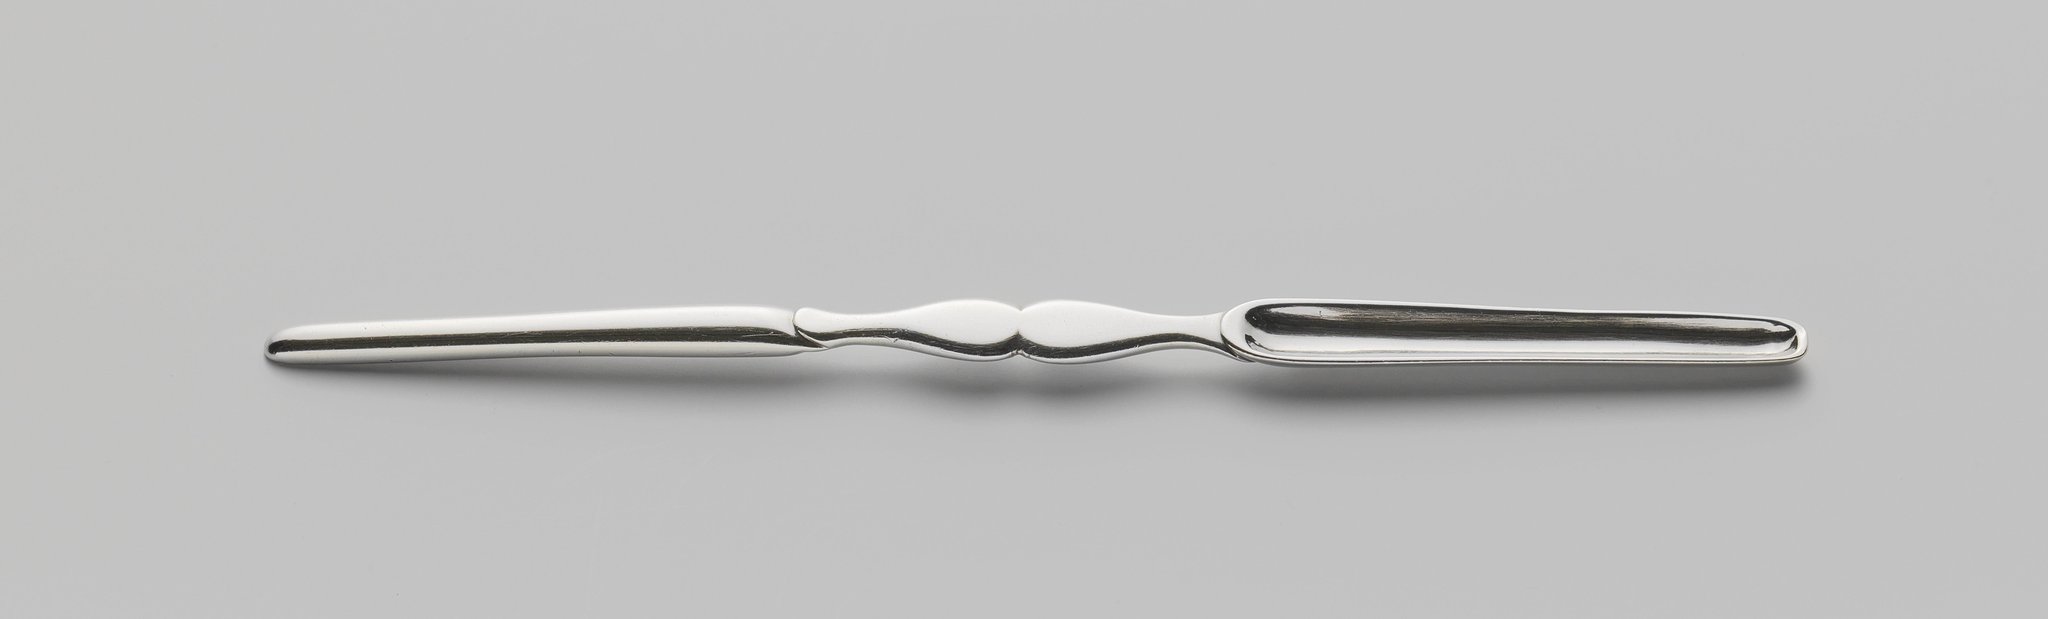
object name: marrow scoop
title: Mergboor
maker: johannes keeman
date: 1805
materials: silver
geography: dordrecht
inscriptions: mark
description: Mergboor van zilver, bestaande uit 2 boren. De ene is ten opzichte van de ander een halve slag gedraaid.